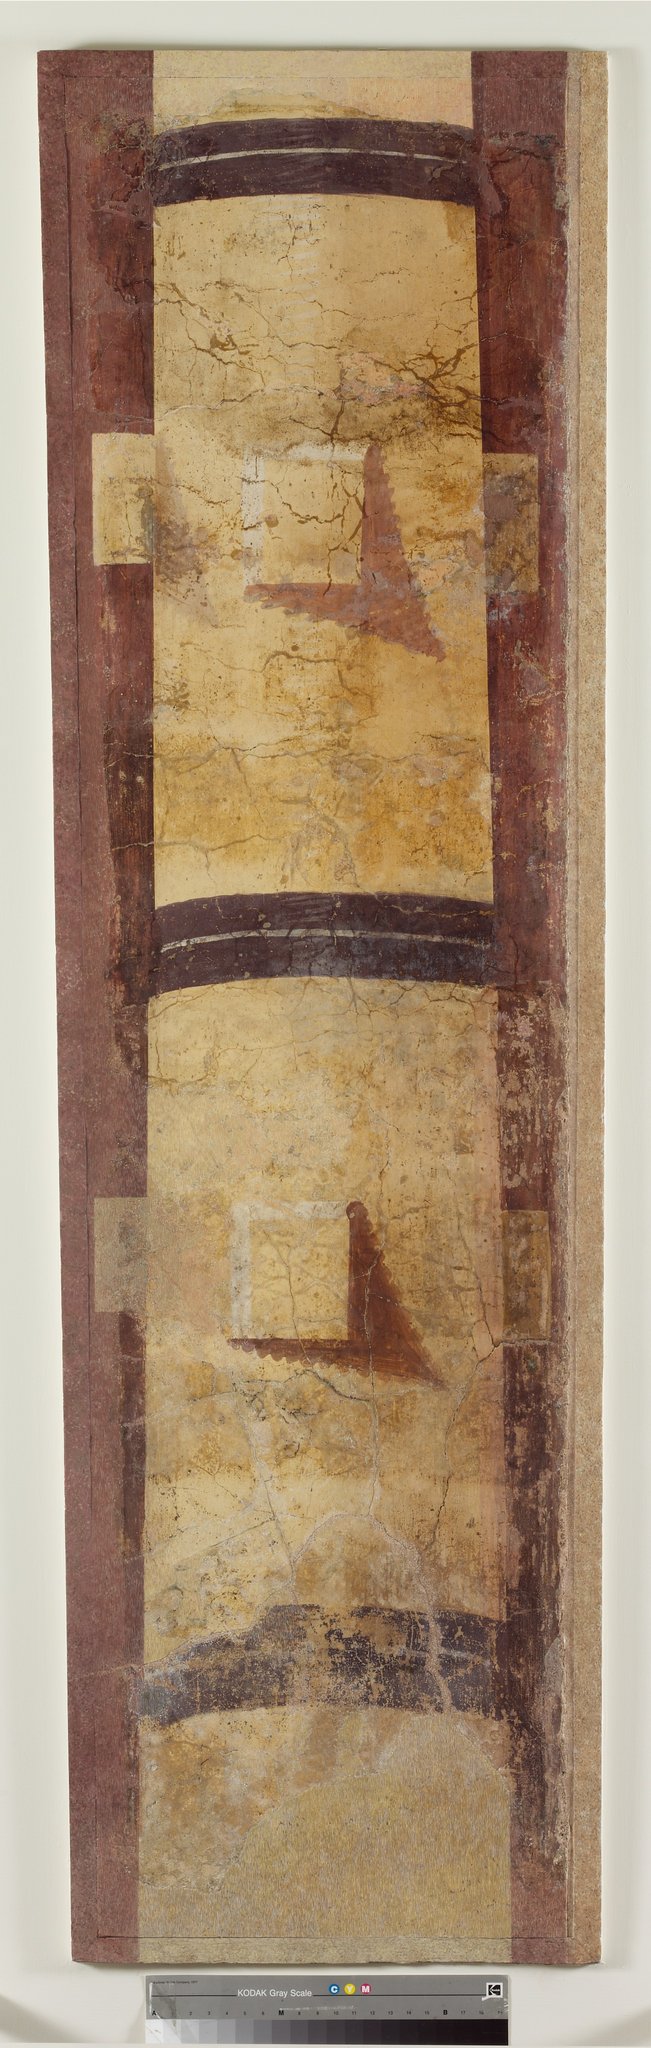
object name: wall painting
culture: roman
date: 40-30 BCE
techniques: fresco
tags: columns